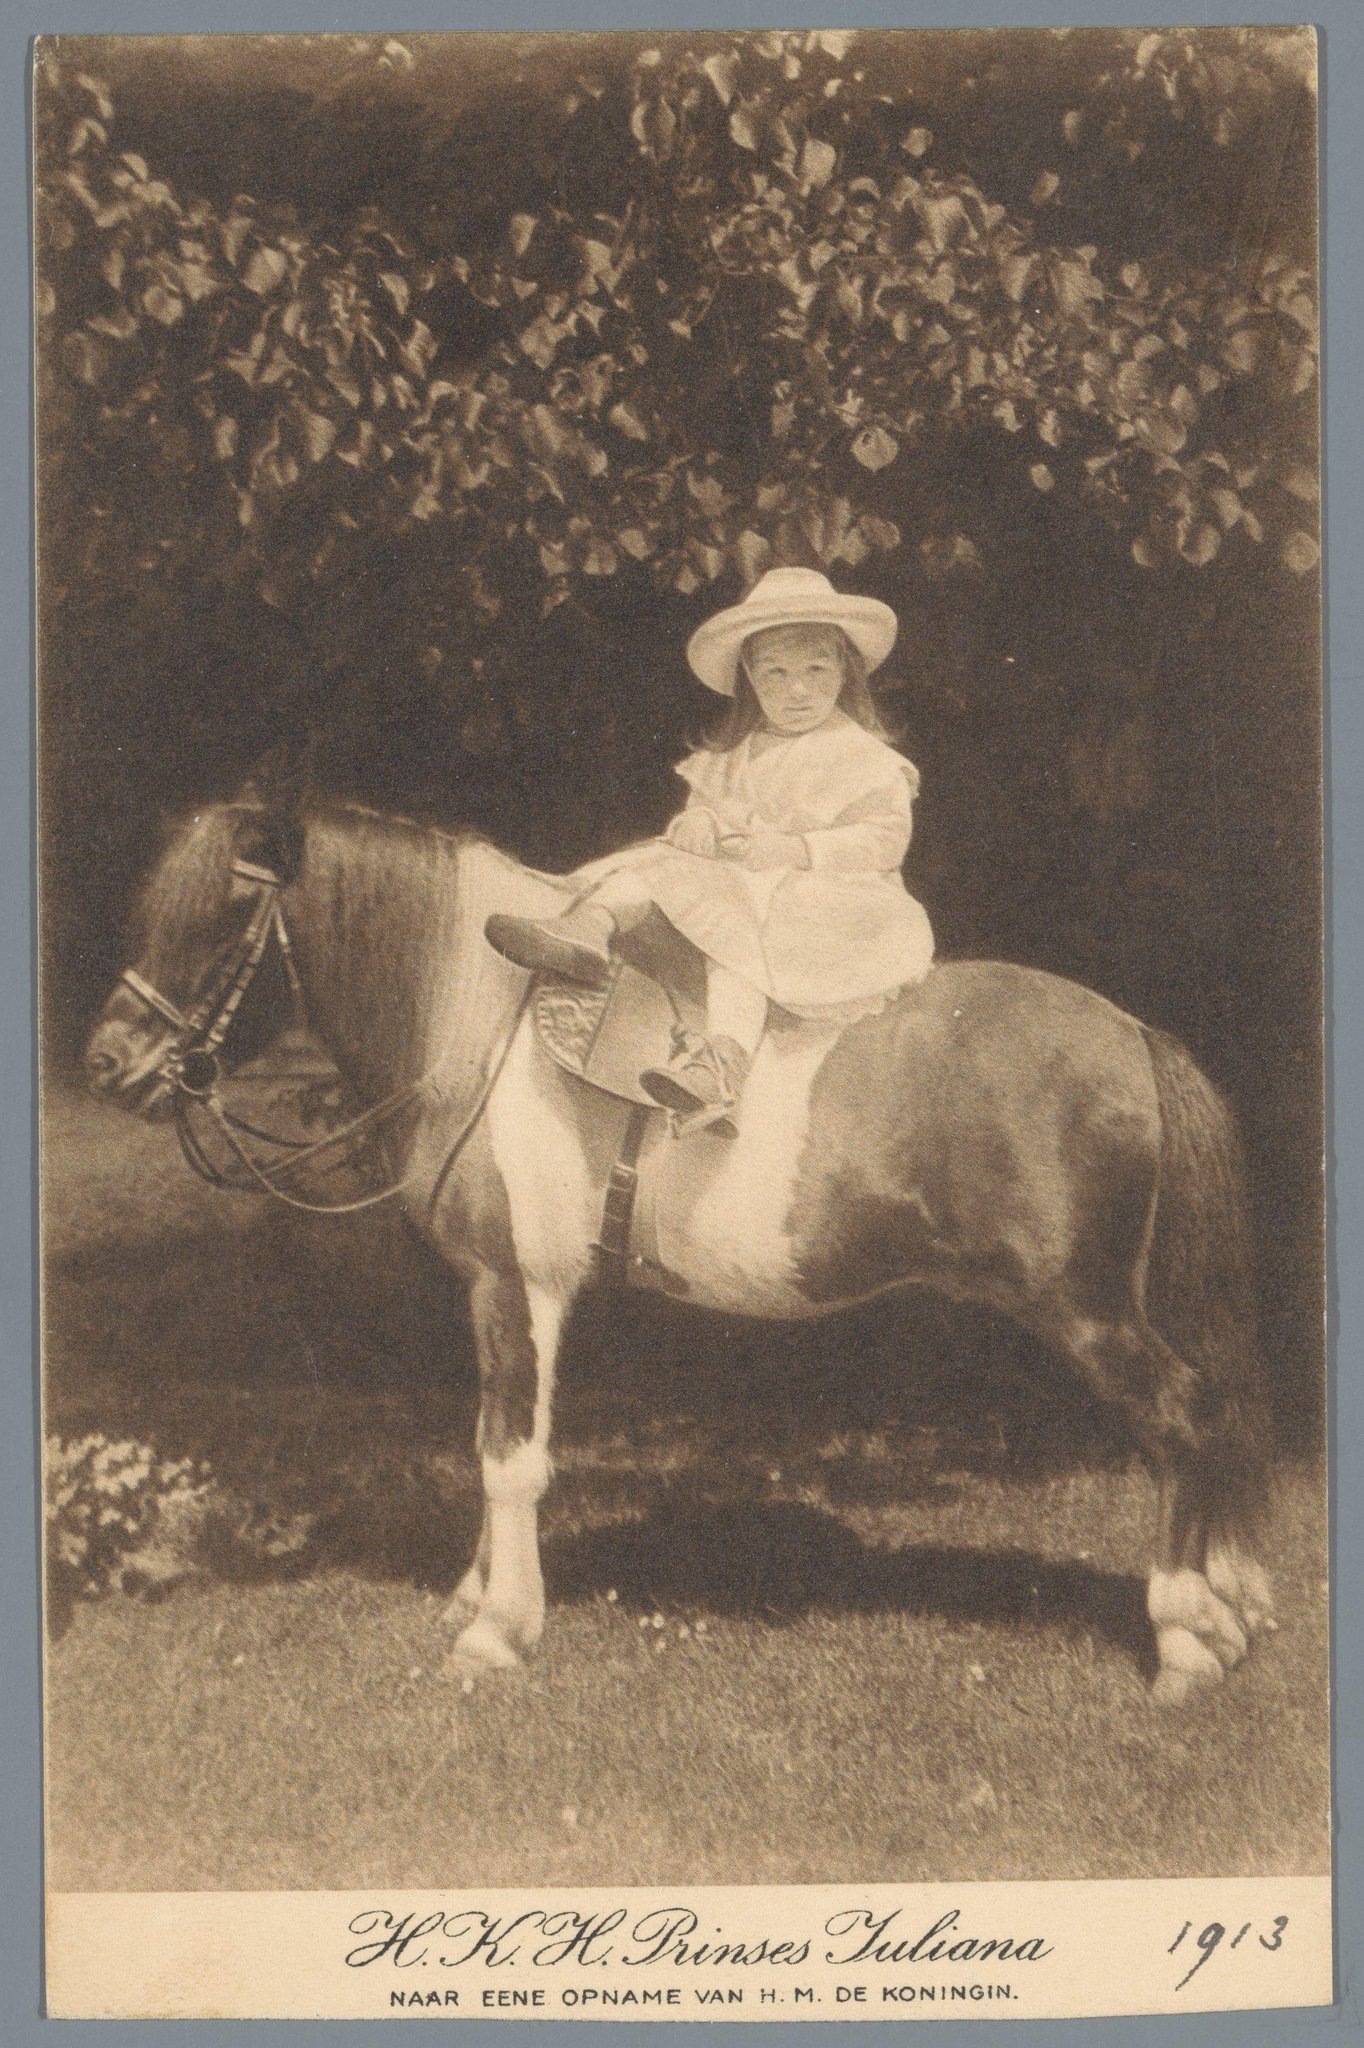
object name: ansichtkaart, prentbriefkaart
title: H.K.H. prinses Juliana, naar eene opname van H.M. de koningin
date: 1913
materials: cardboard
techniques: photograph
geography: amsterdam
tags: the hague, juliana of the netherlands, crown princess, horse